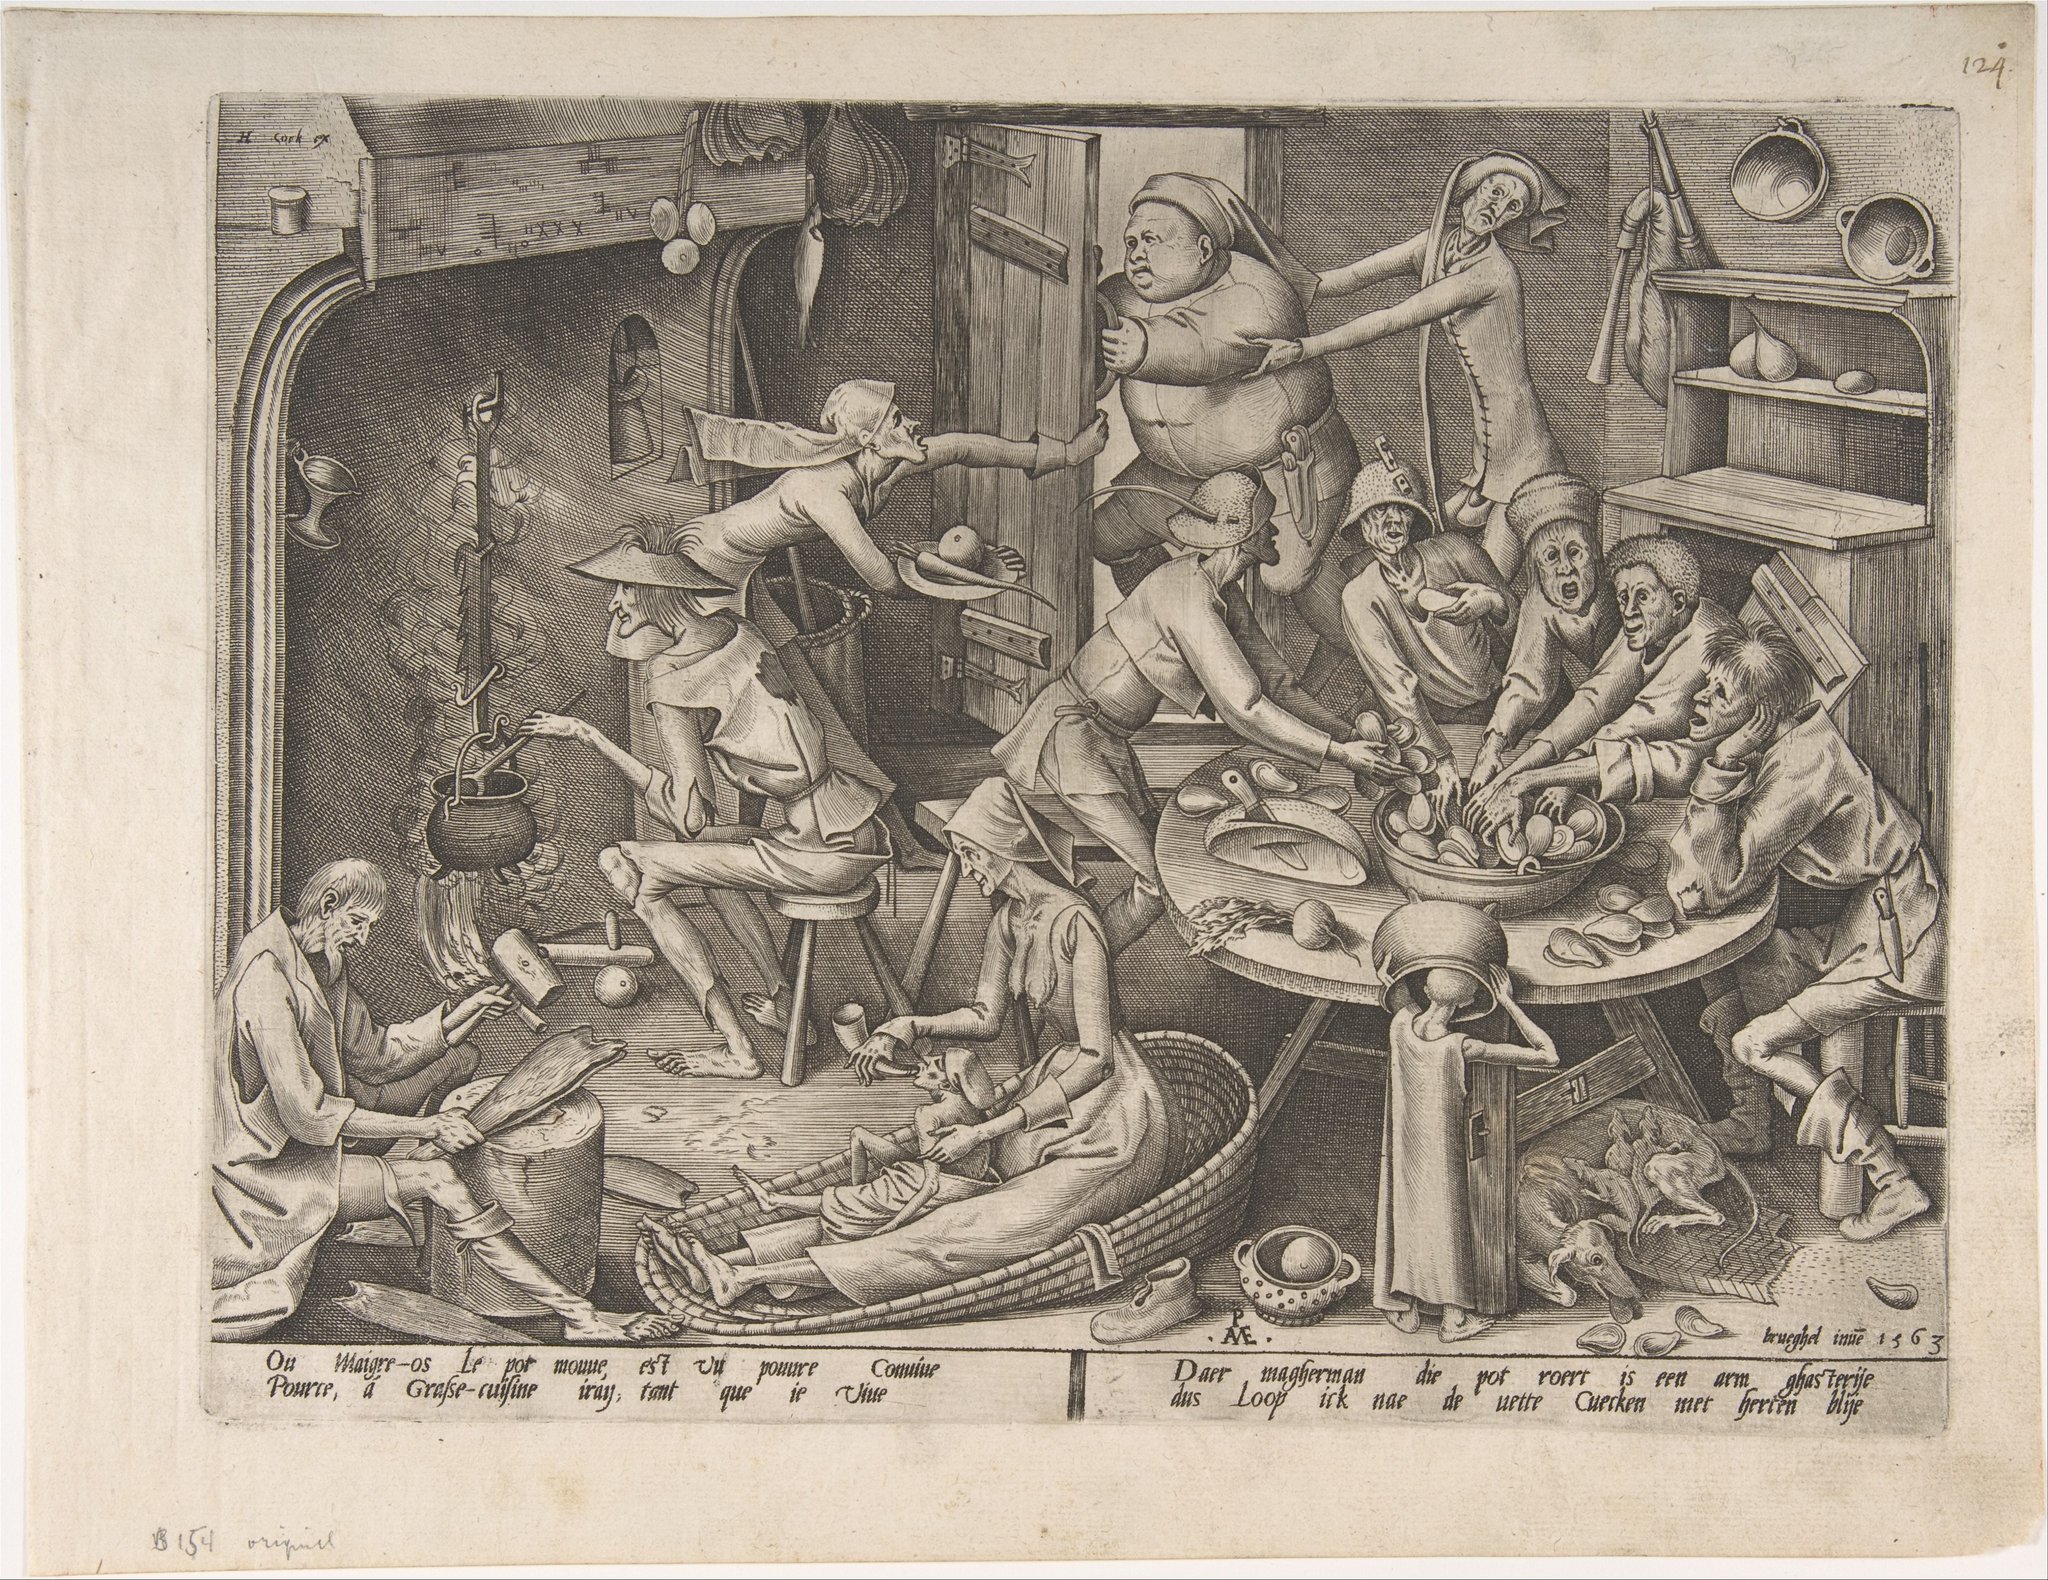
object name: print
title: The Thin Kitchen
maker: pieter bruegel the elder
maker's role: artist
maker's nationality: netherlandish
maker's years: 1525-1569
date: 1563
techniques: engraving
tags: kitchens,men,women,working